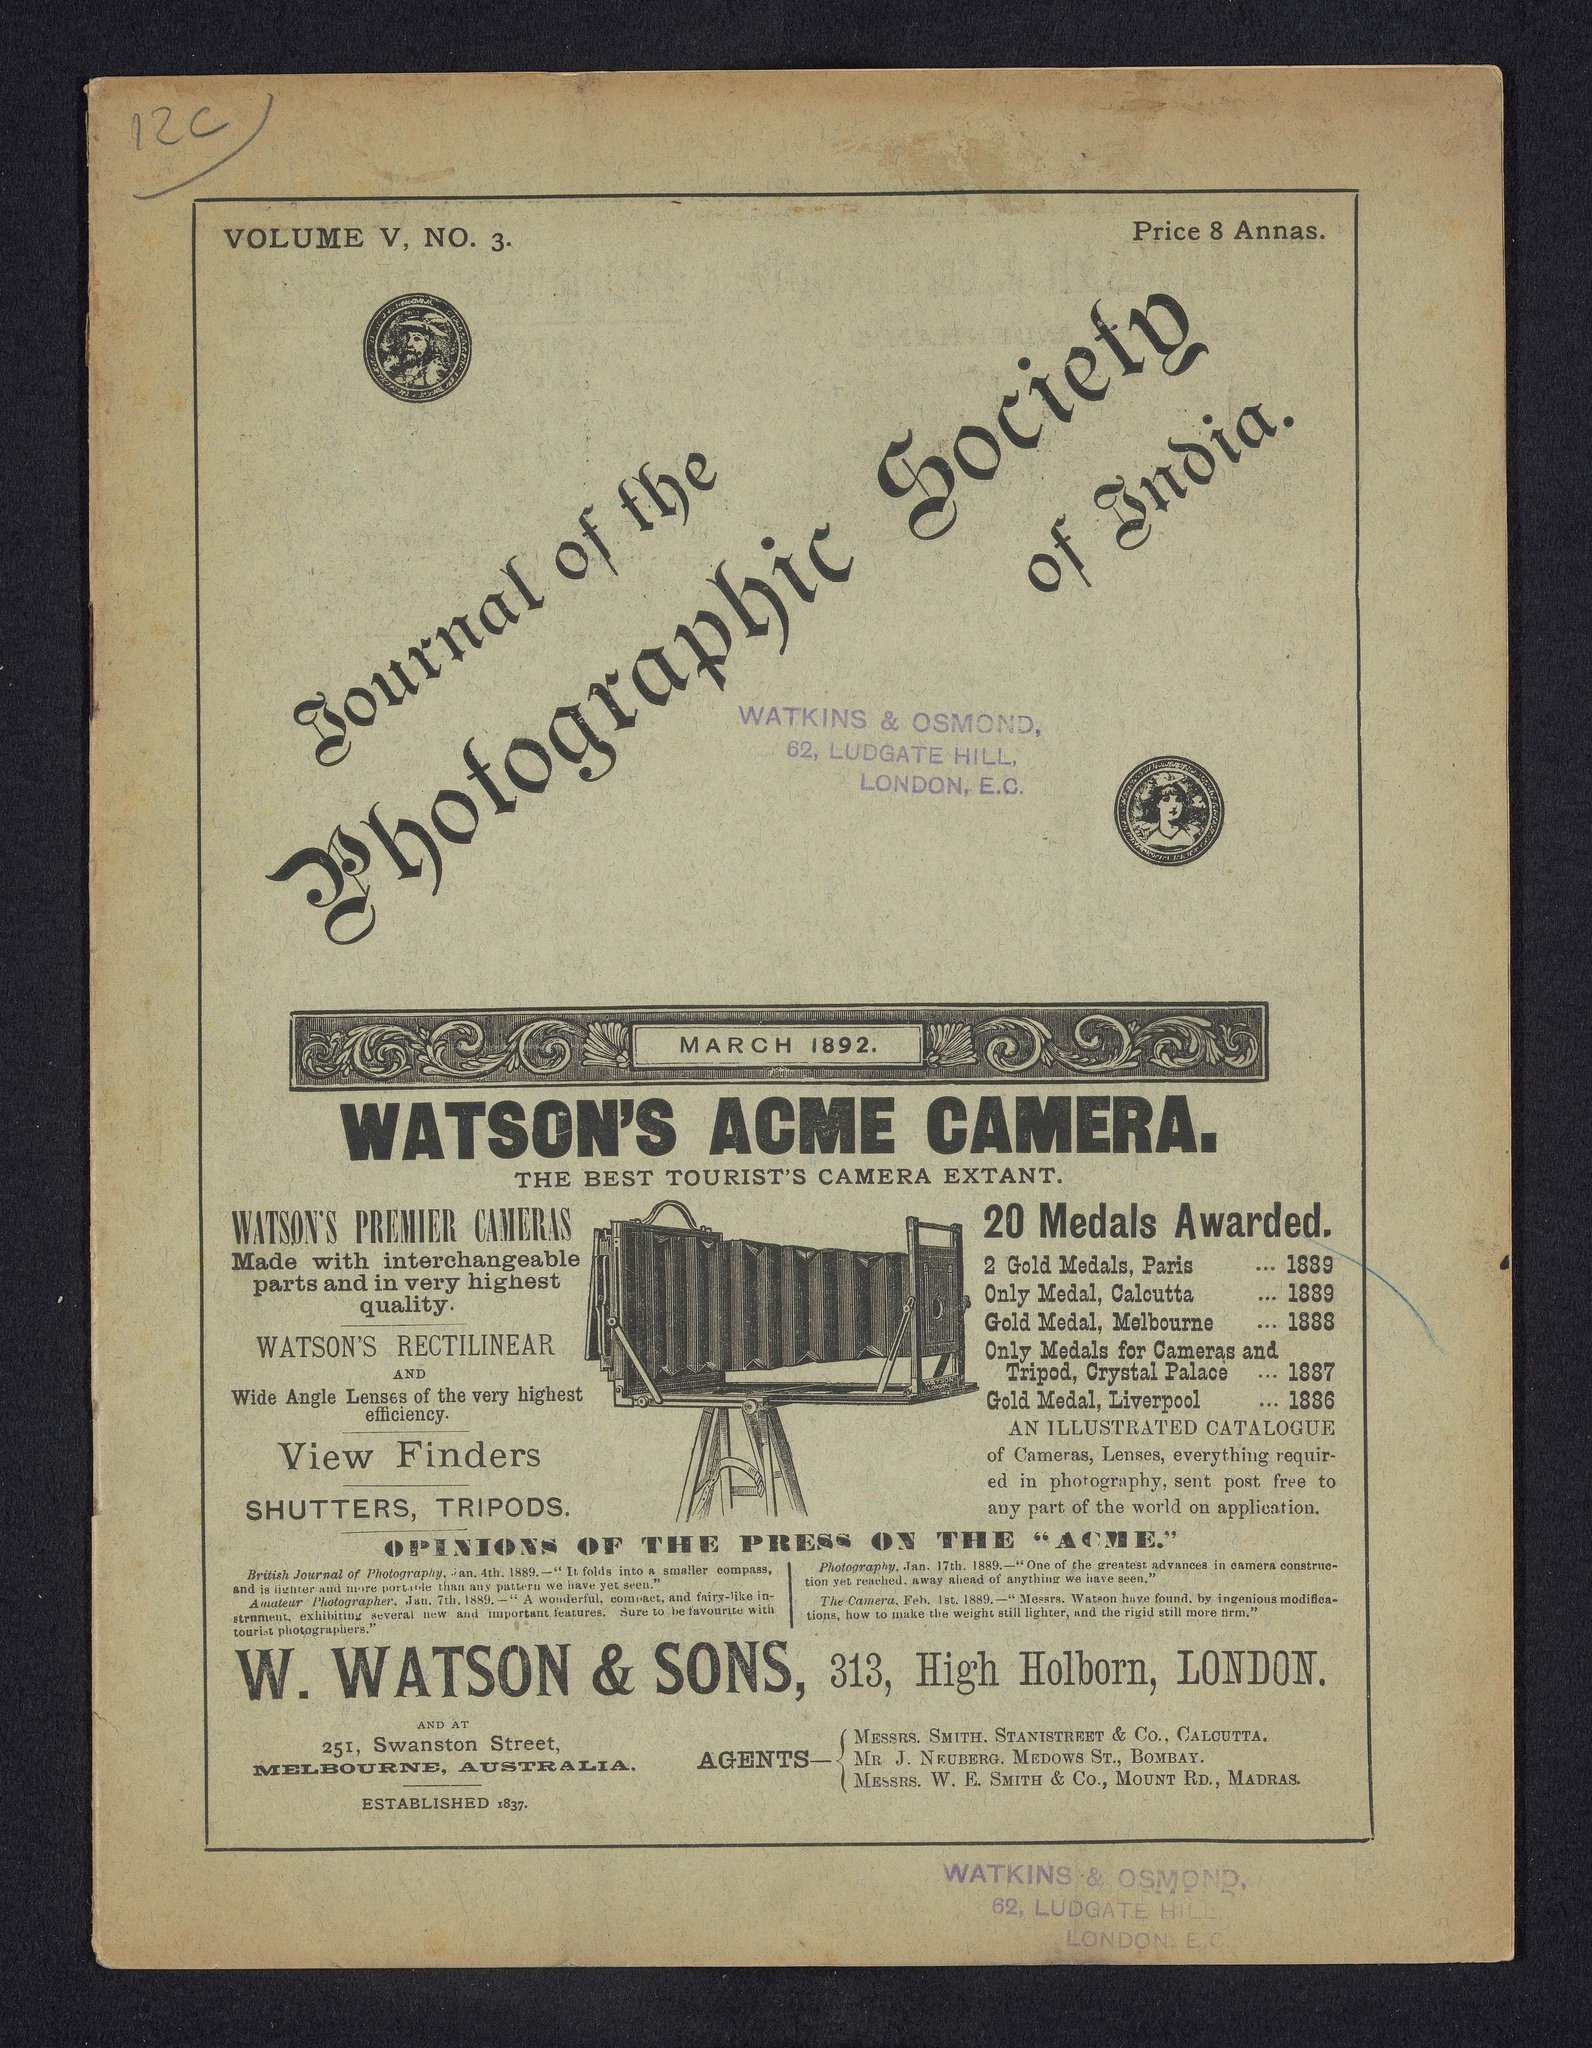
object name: book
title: The journal of the Photographic Society of India Volume V. No.3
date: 1892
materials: paper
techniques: photograph, printing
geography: kolkata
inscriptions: name: ‘Watkins & Osmond. 62, Ludgate Hill, London, E.C.’